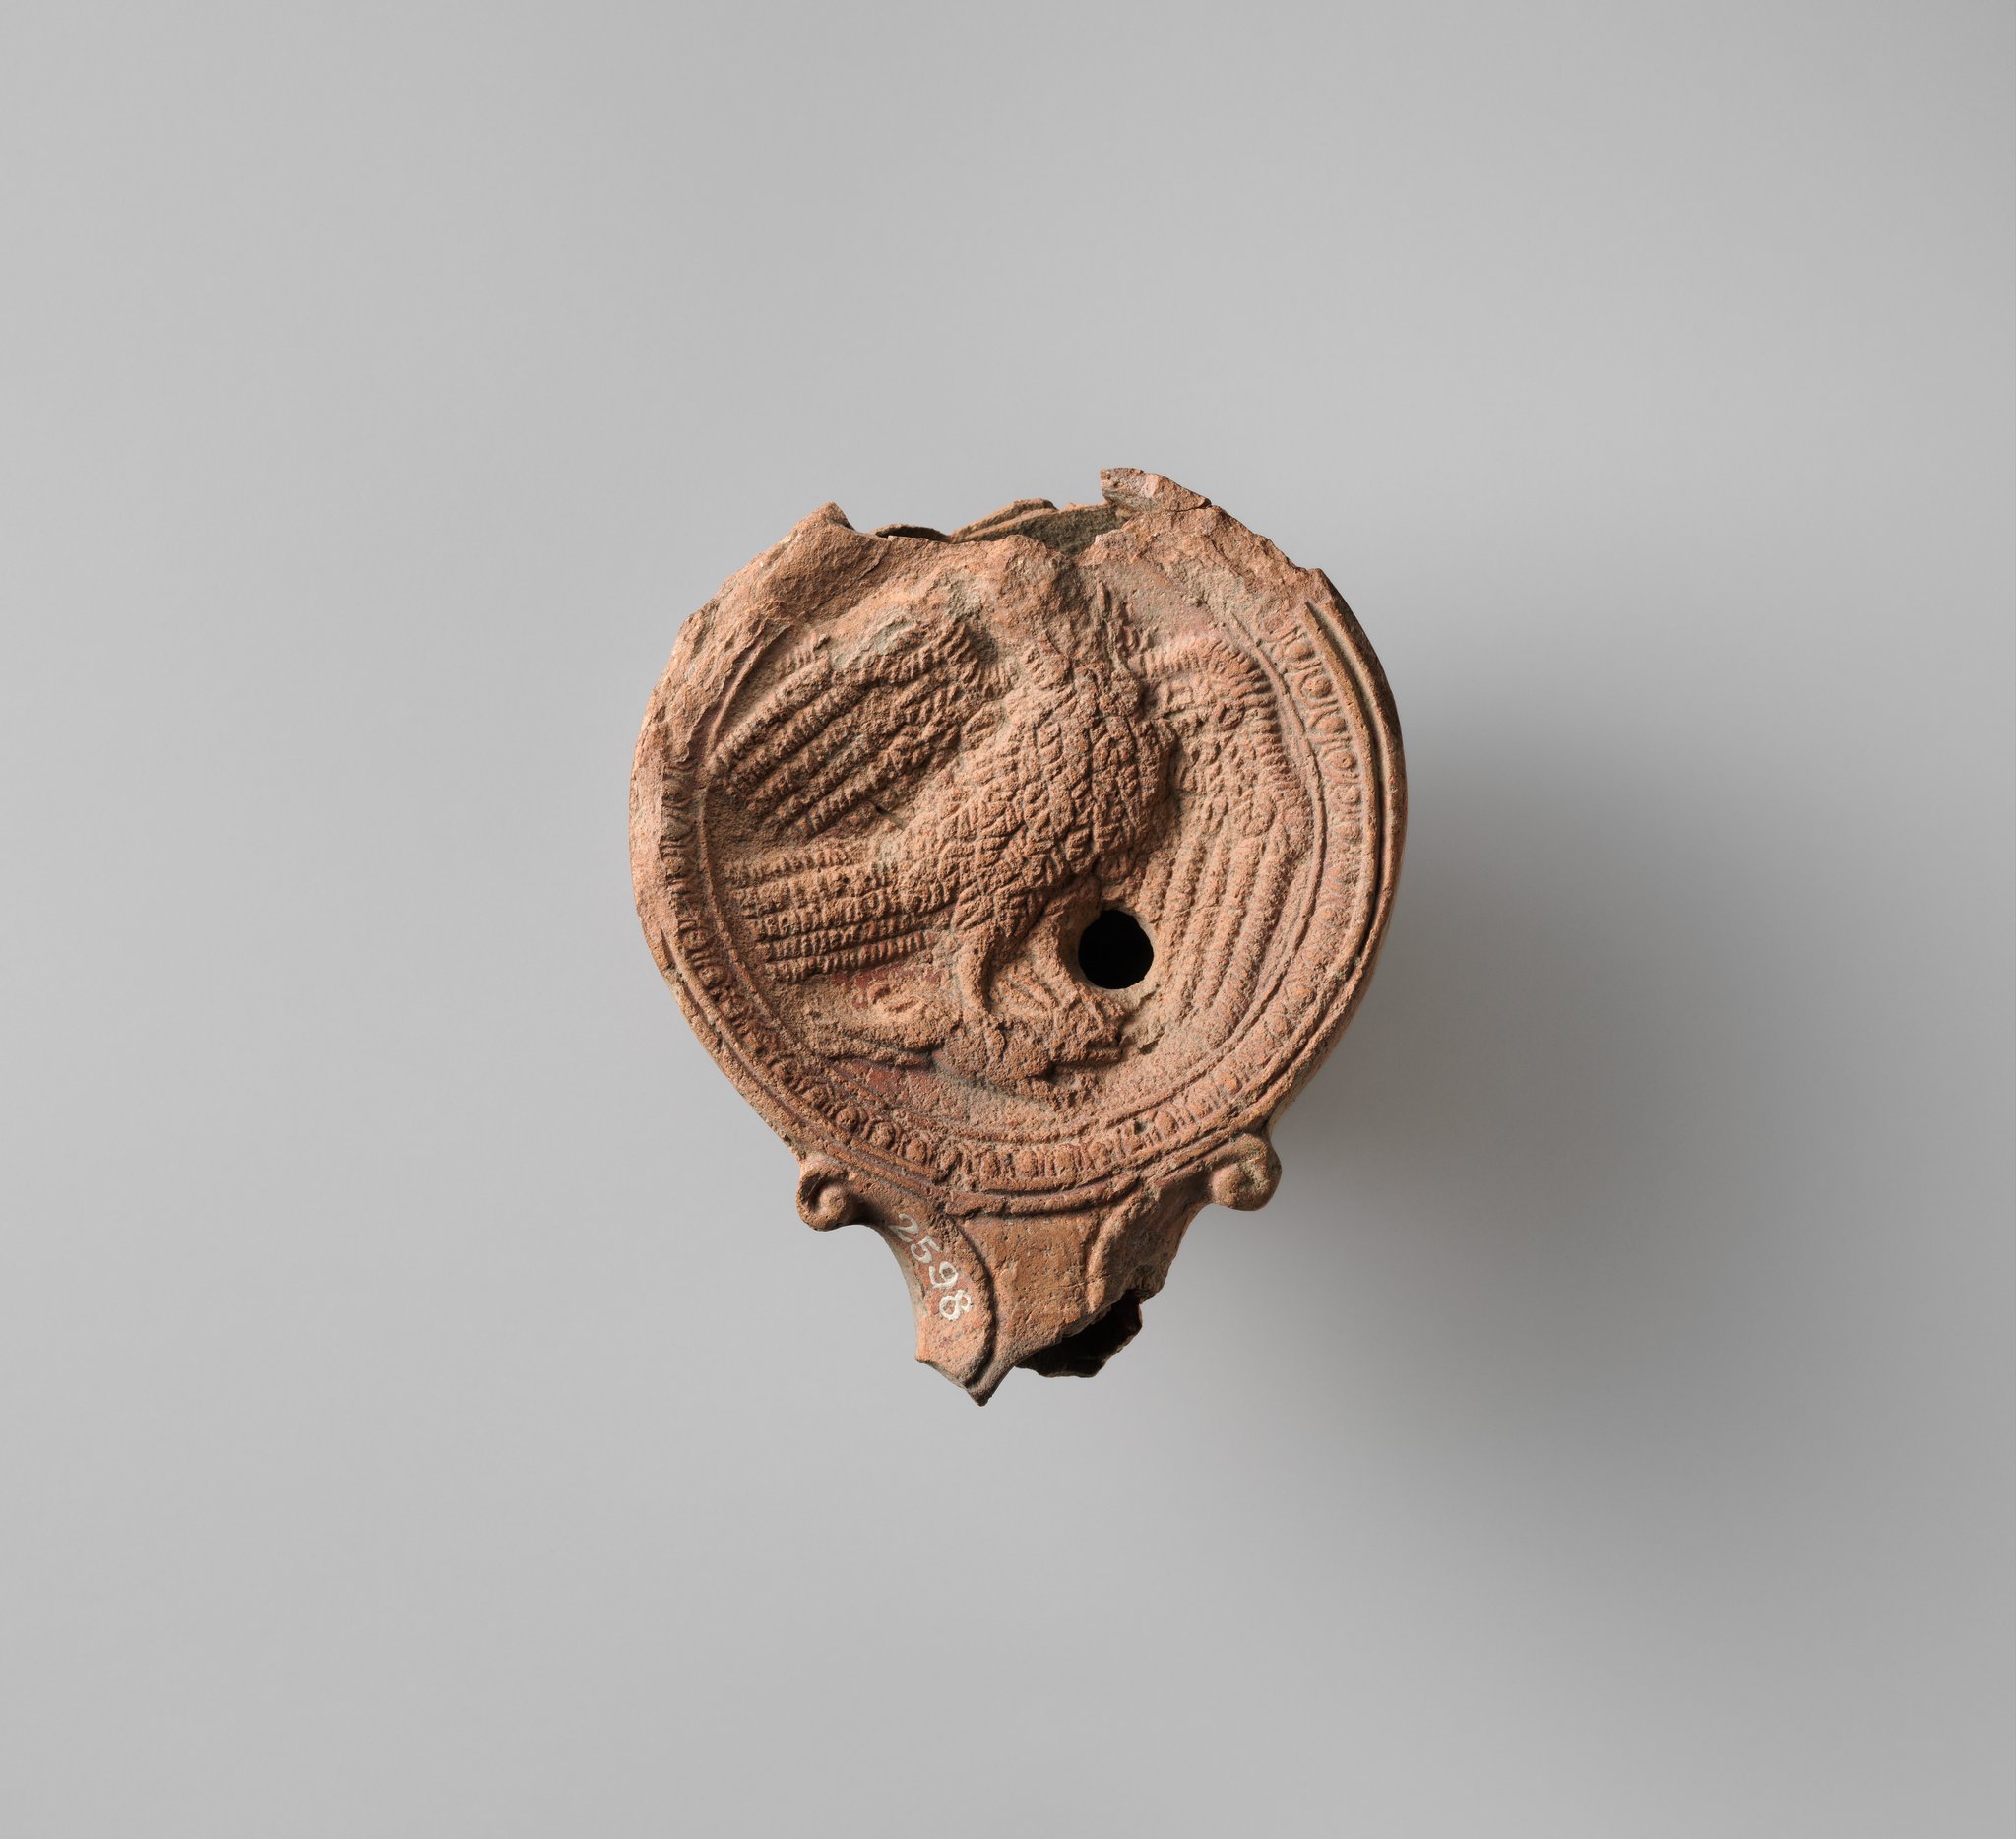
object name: lamp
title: Terracotta oil lamp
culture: roman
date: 100 BCE-100 CE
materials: terracotta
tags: eagles,rabbits